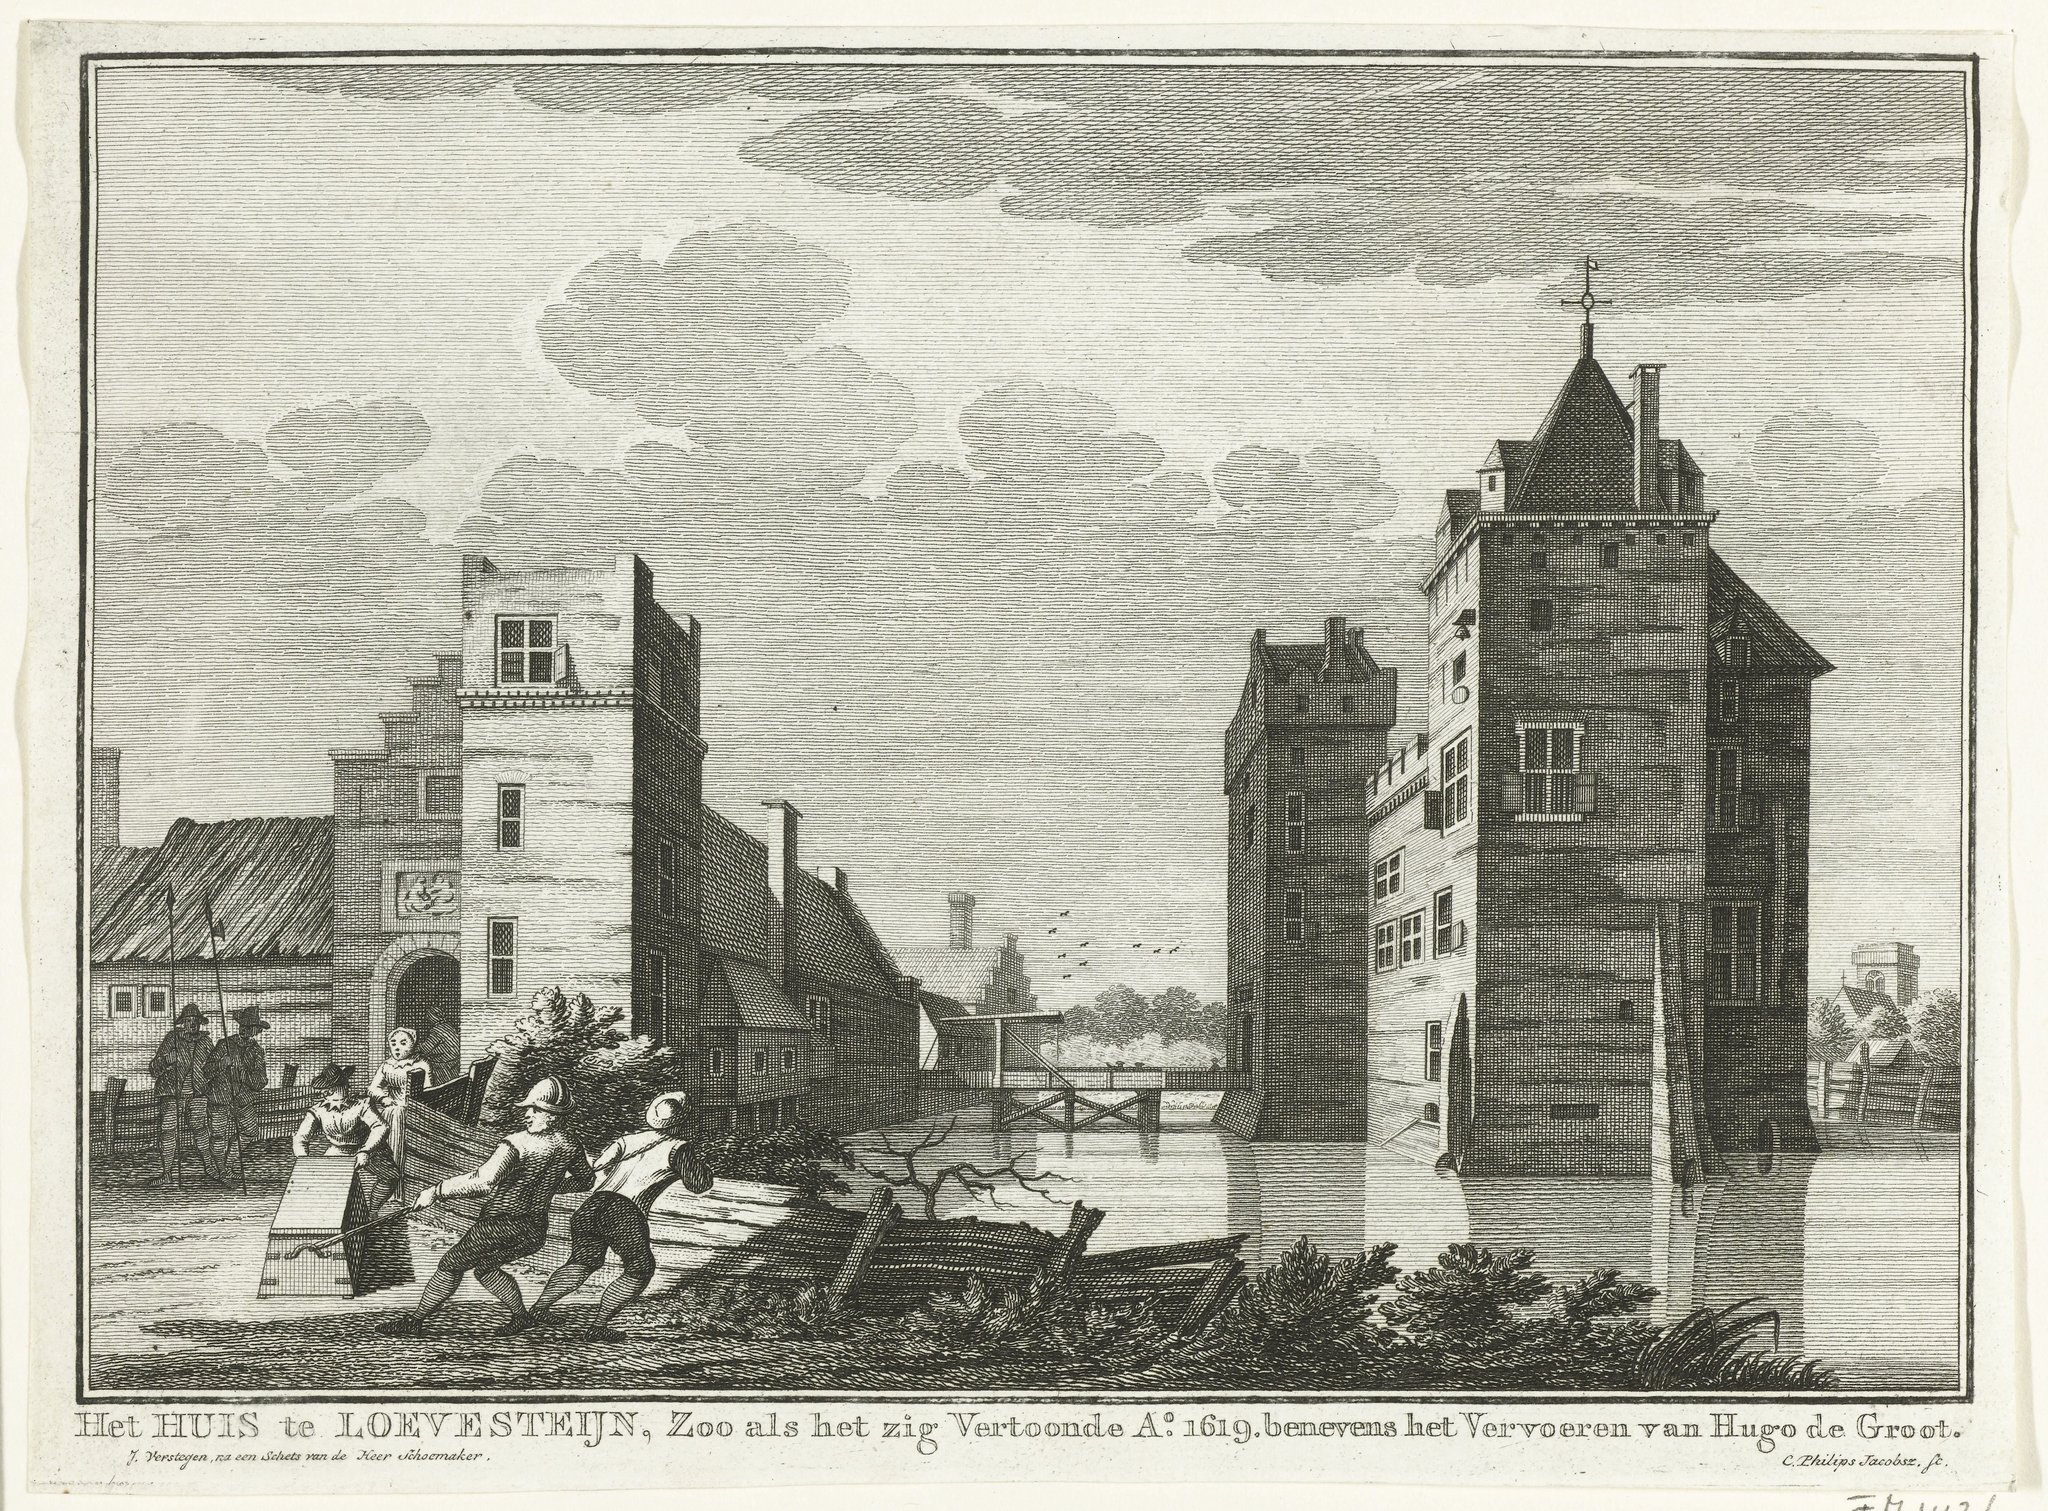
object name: history print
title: Het huis te Loevesteijn, zoo als het zig vertoonde ao. 1619. benevens het vervoeren van Hugo de Groot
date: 1752-1789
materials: paper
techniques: etching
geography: amsterdam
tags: delft, hugo de groot, castle, law and jurisprudence (+ escape from prison), loevestein castle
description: Gezicht op Slot Loevestein met links op de voorgrond de ontsnapping van Hugo de Groot in de boekenkist, 22 maart 1621. Mannen slepen de kist aan een touw.